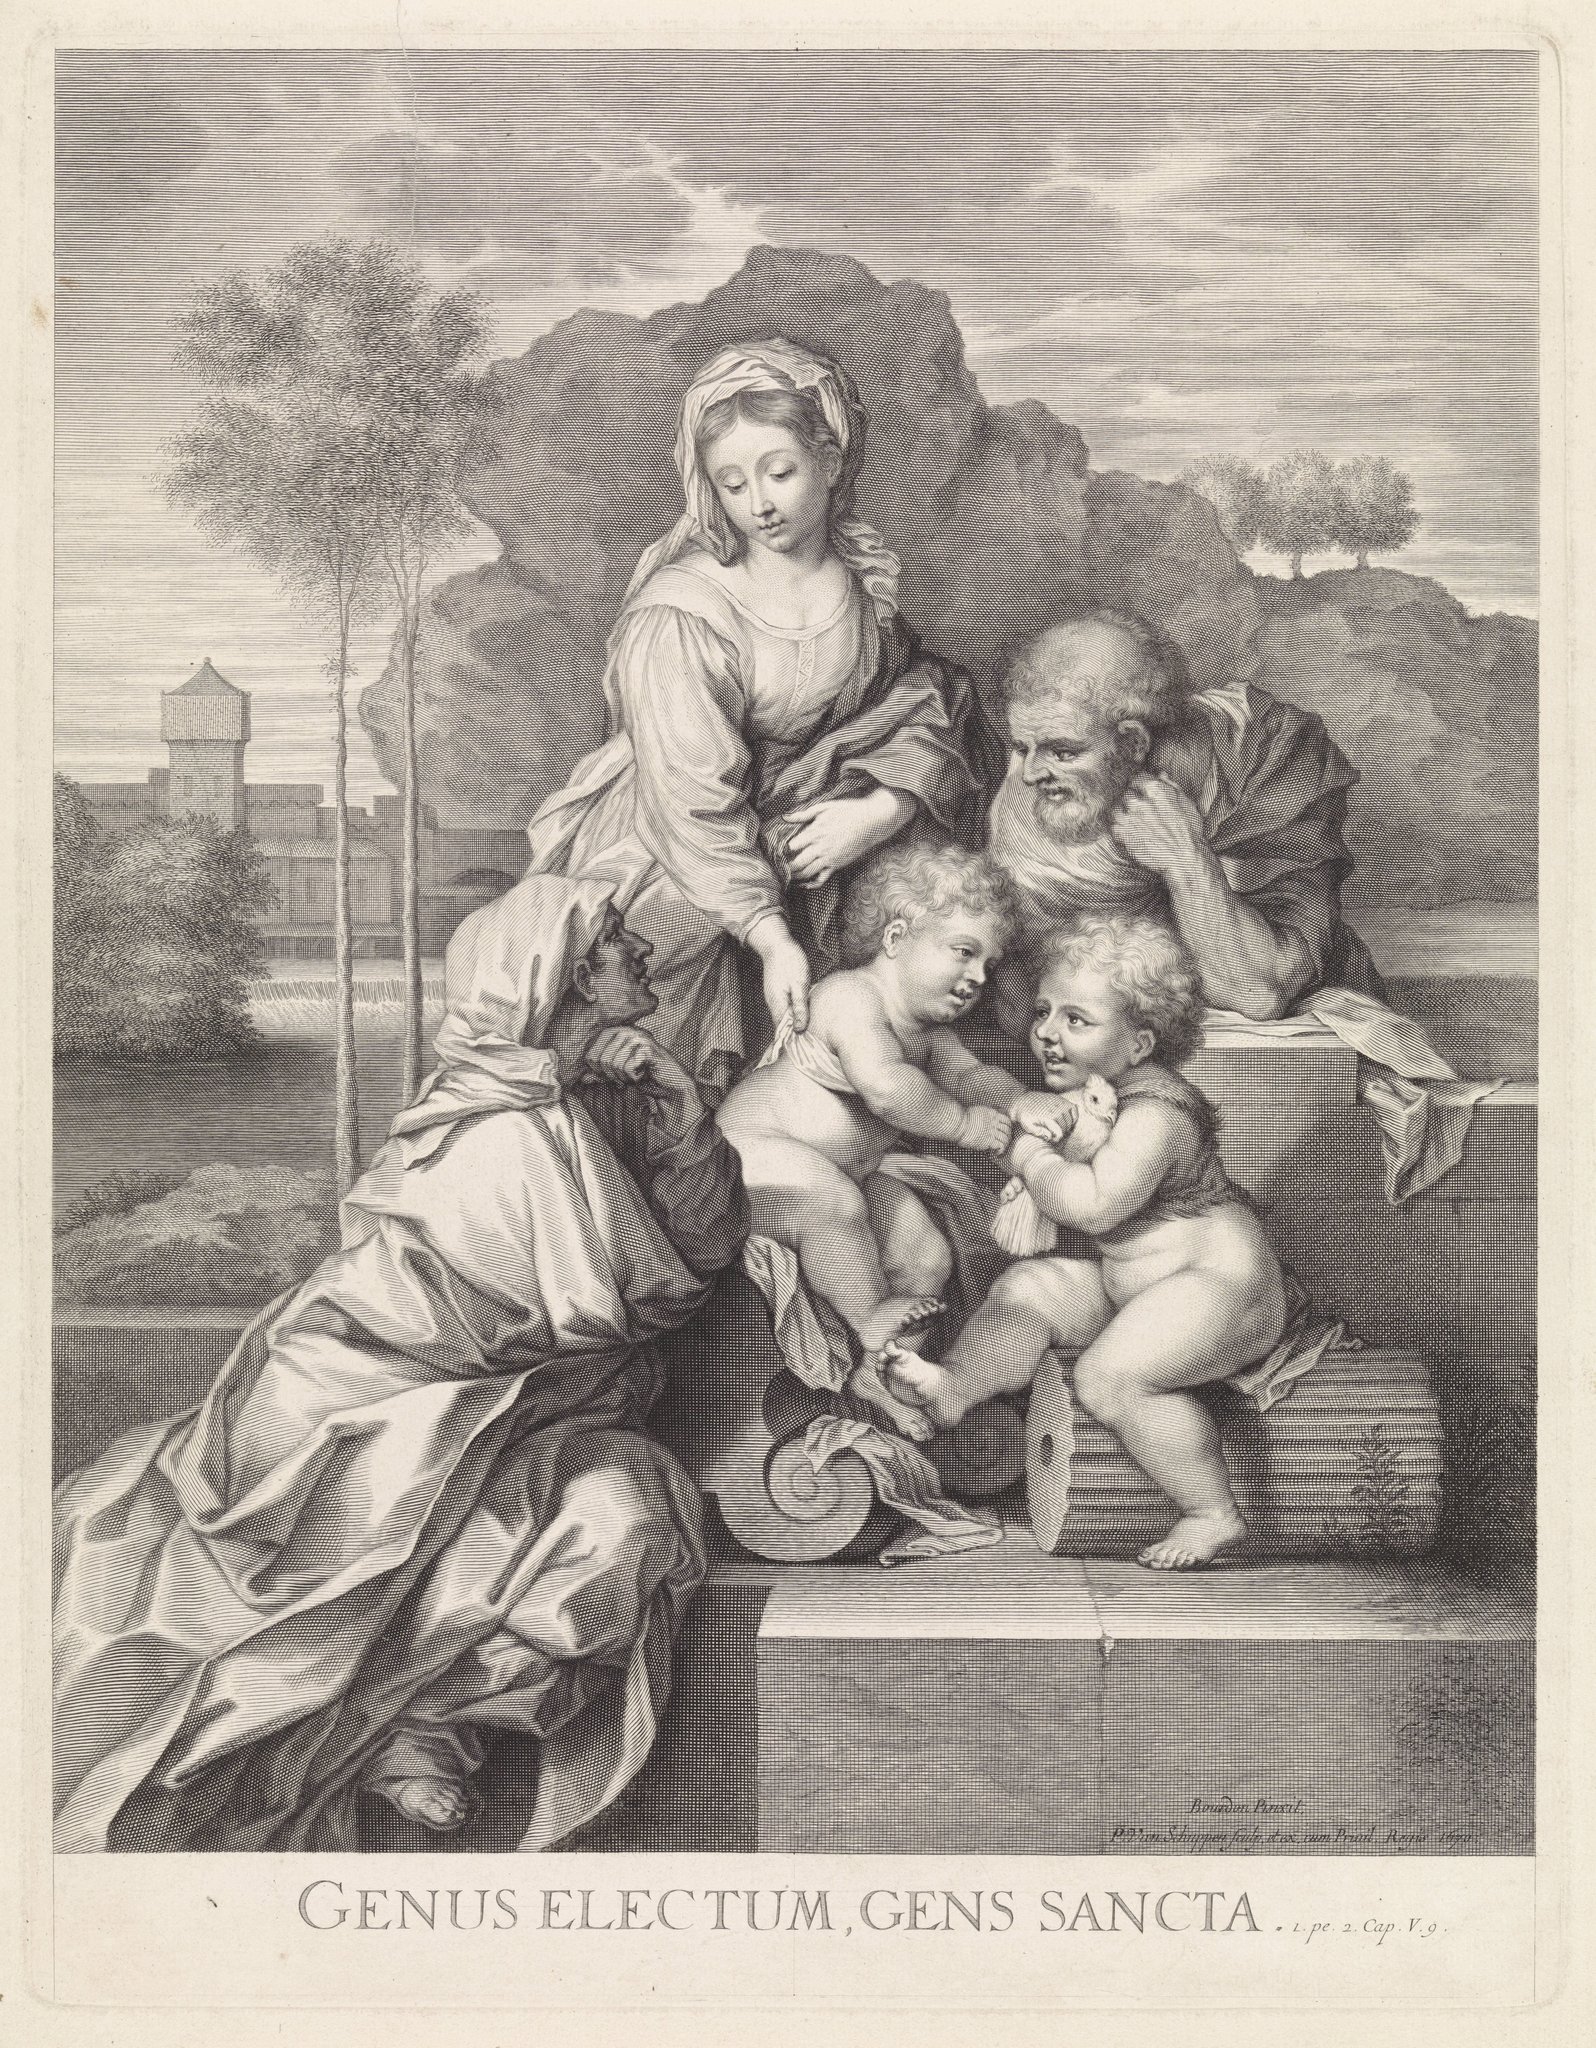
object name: print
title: Heilige familie met Elisabet en Johannes de Doper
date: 1670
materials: paper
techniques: engraving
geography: paris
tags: holy family with john the baptist (as child)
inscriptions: collector's mark: Lugt 240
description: Landschap met de heilige familie. Maria steunt het Christuskind, dat op een voetstuk zit, in de rug. Het kind reikt naar Johannes de Doper die een duif in zijn armen houdt. Elisabet en Jozef buigen zich naar Christus. In de marge een tekst uit 1 Petr. 2:9.